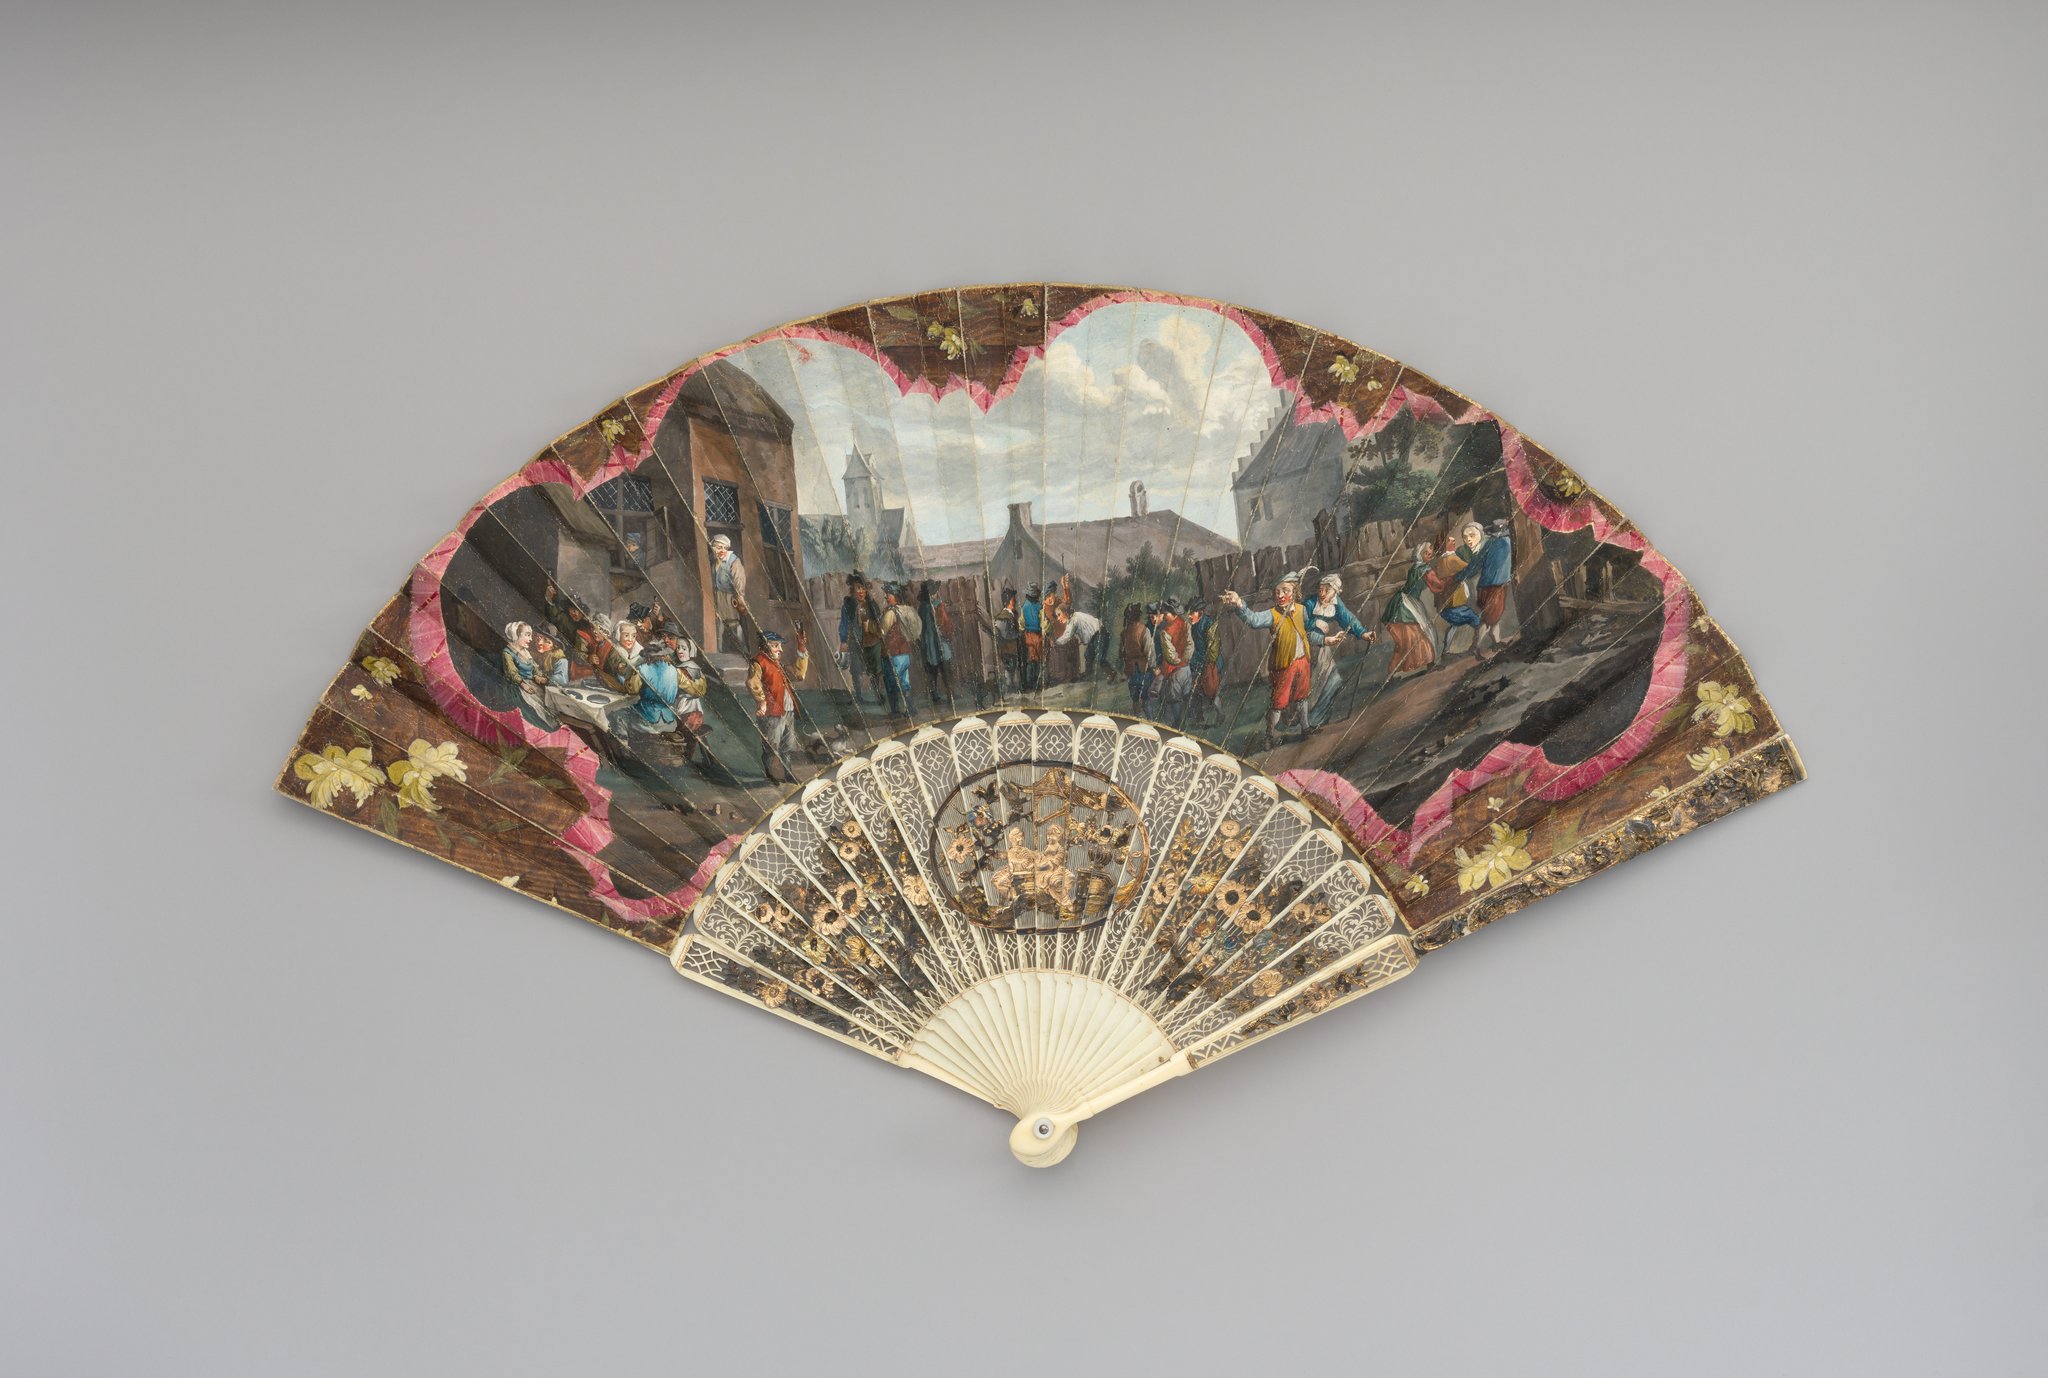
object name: fan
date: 1701-1800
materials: ivory, paper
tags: men,women